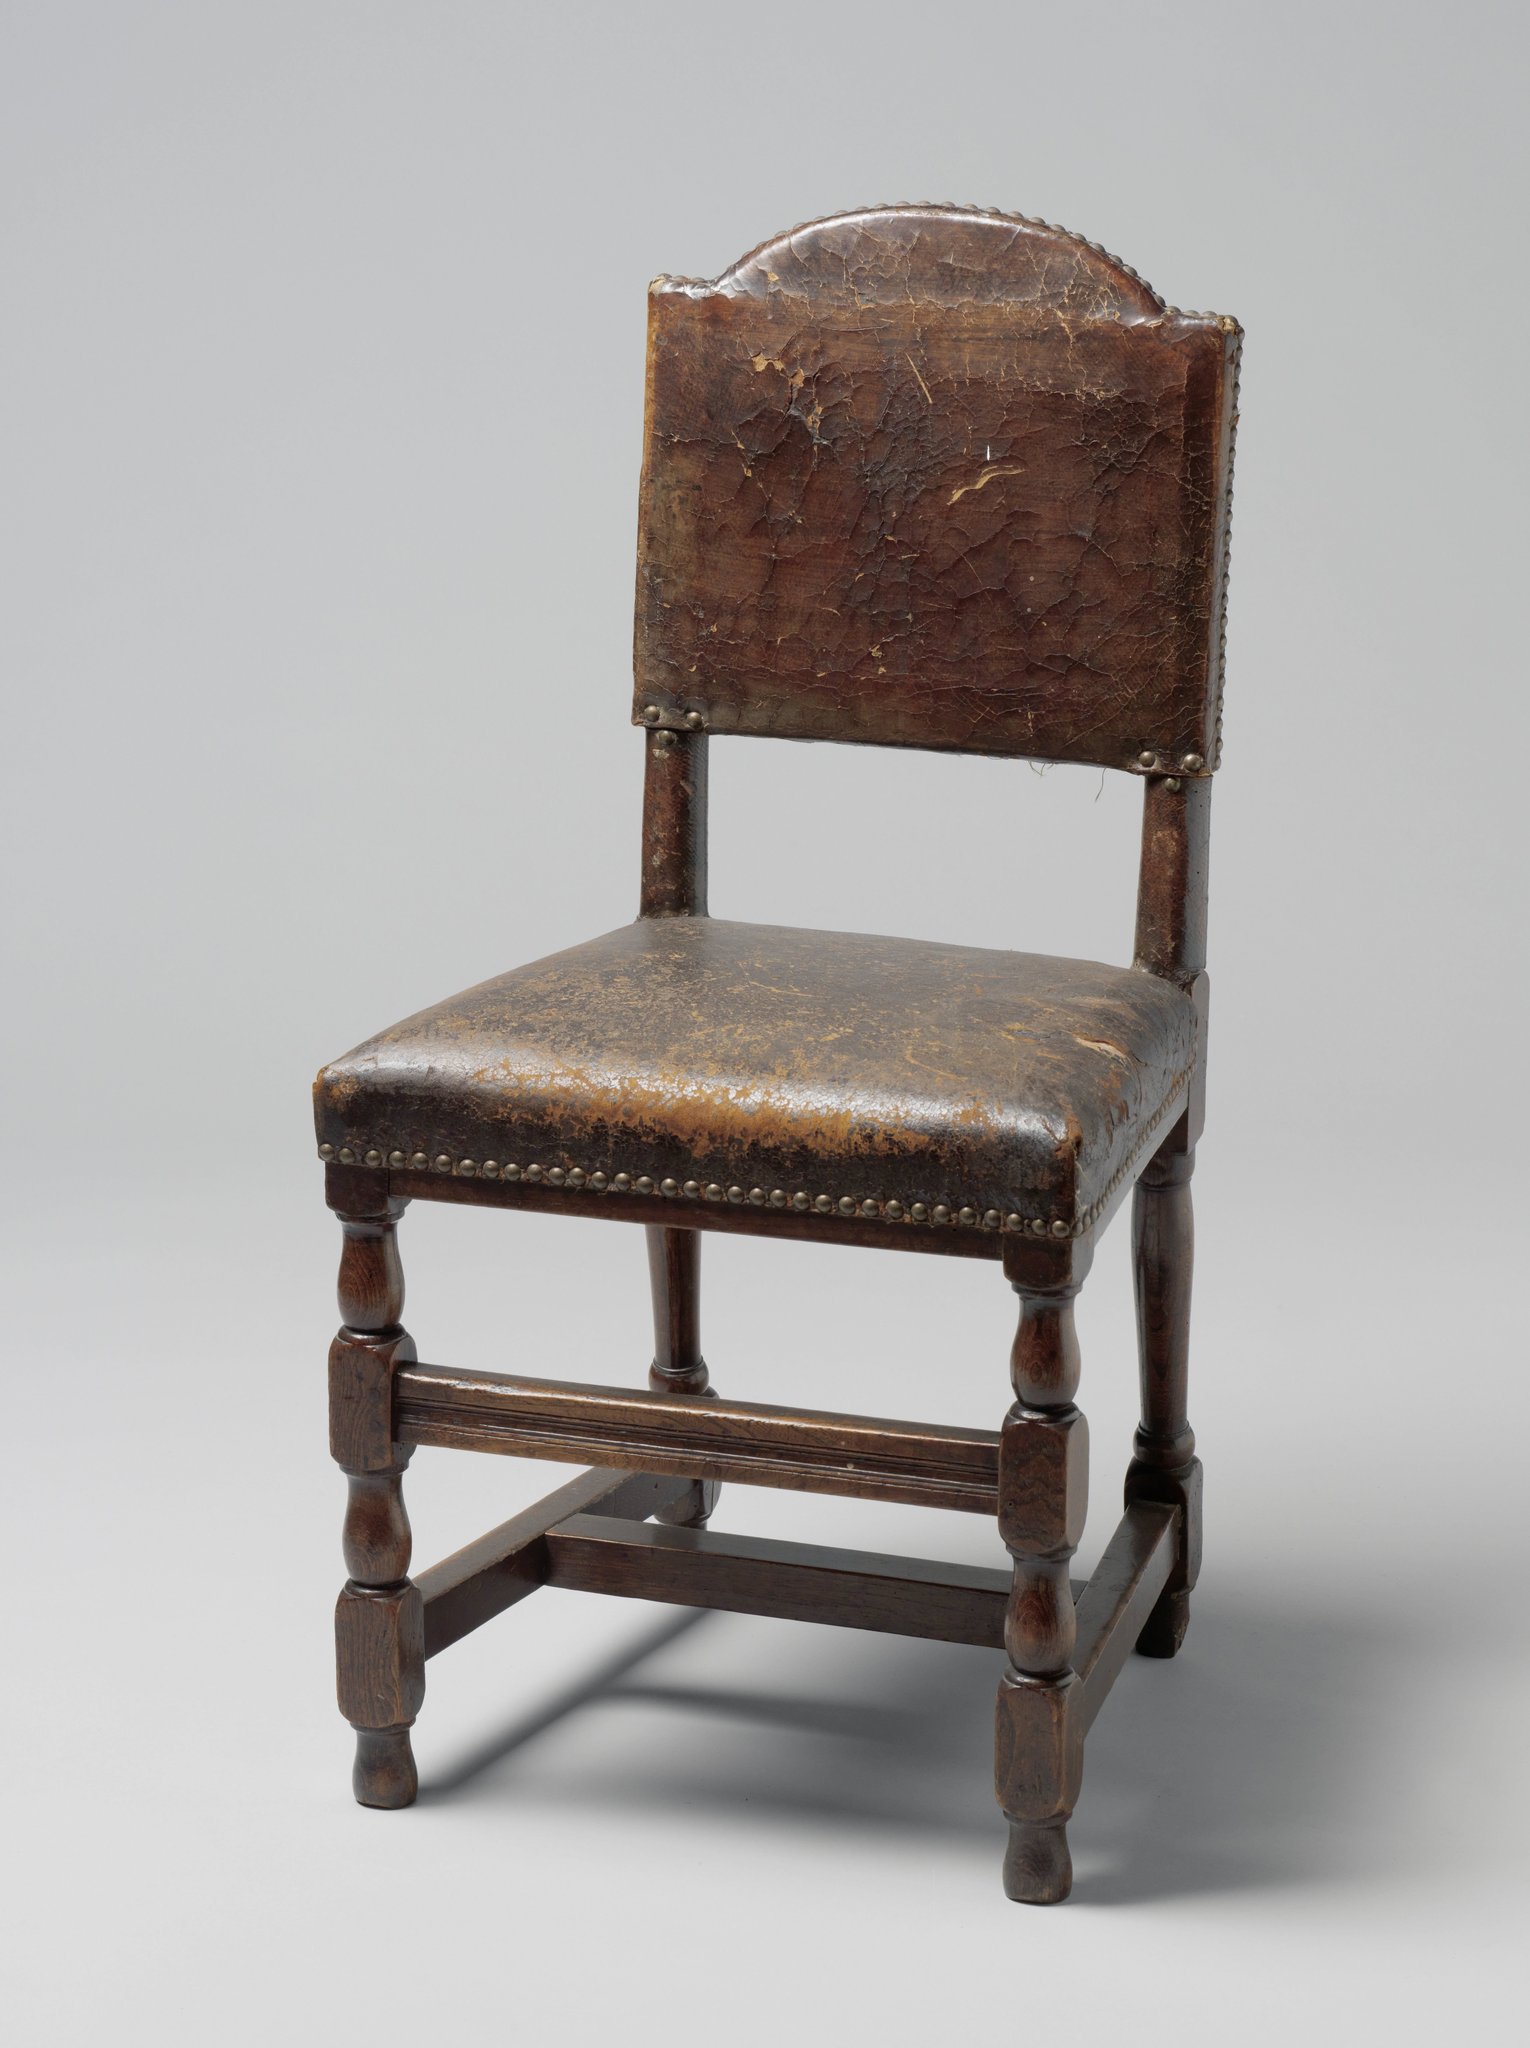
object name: furniture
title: Stoel van eikenhout met zitting en rug van leer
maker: Anonymous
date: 1675-1700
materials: wood, leather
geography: netherlands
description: Acht eikenhouten stoelen met leren zitting en rug. De poten vertonen huis en geleden en zijn verbonden door een H-vormig kruis. Aan de voorzijde bevindt zich, tussen twee huizen, een brede voorsport. De achterpoten wijken naar achteren. De rug rust hoog op de stutten en is van boven gebogen.